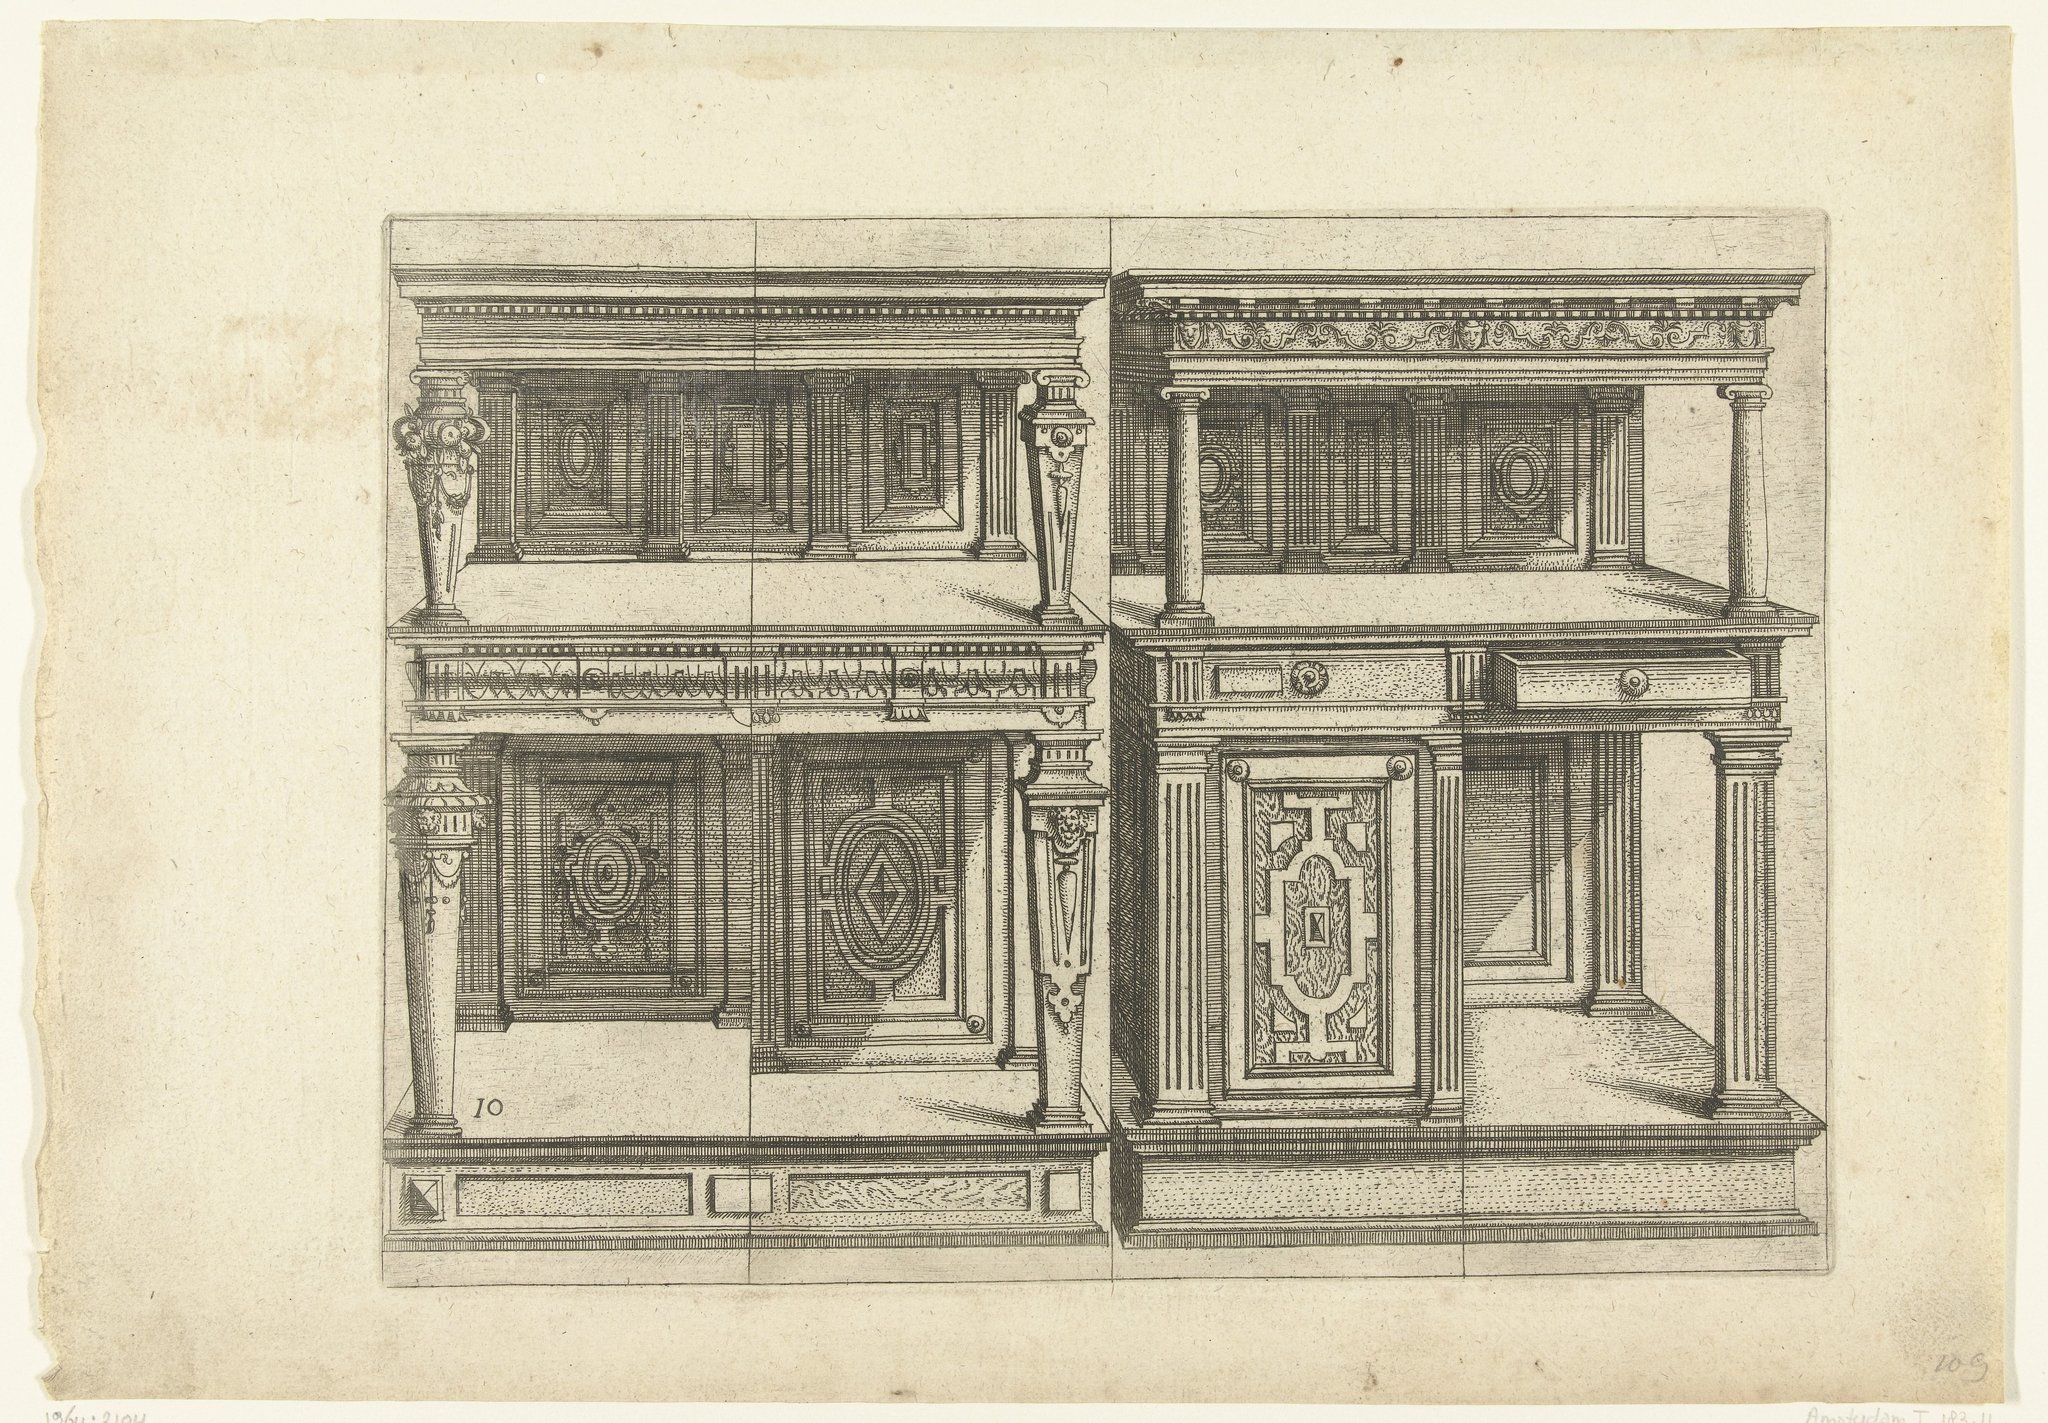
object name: ornament print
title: Differents pourtraits de menuiserie. De reeks zonder titel en zonder blad 16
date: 1583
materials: paper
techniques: etching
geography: netherlands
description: Bij het linker ontwerp zijn de linker en de rechter helft op geheel verschillende wijze gedecoreerd, bij het rechter ontwerp is dit alleen in het onderste gedeelte gebeurd. Blad 10 van 15 genummerde bladen + titelblad uit een serie van 16.